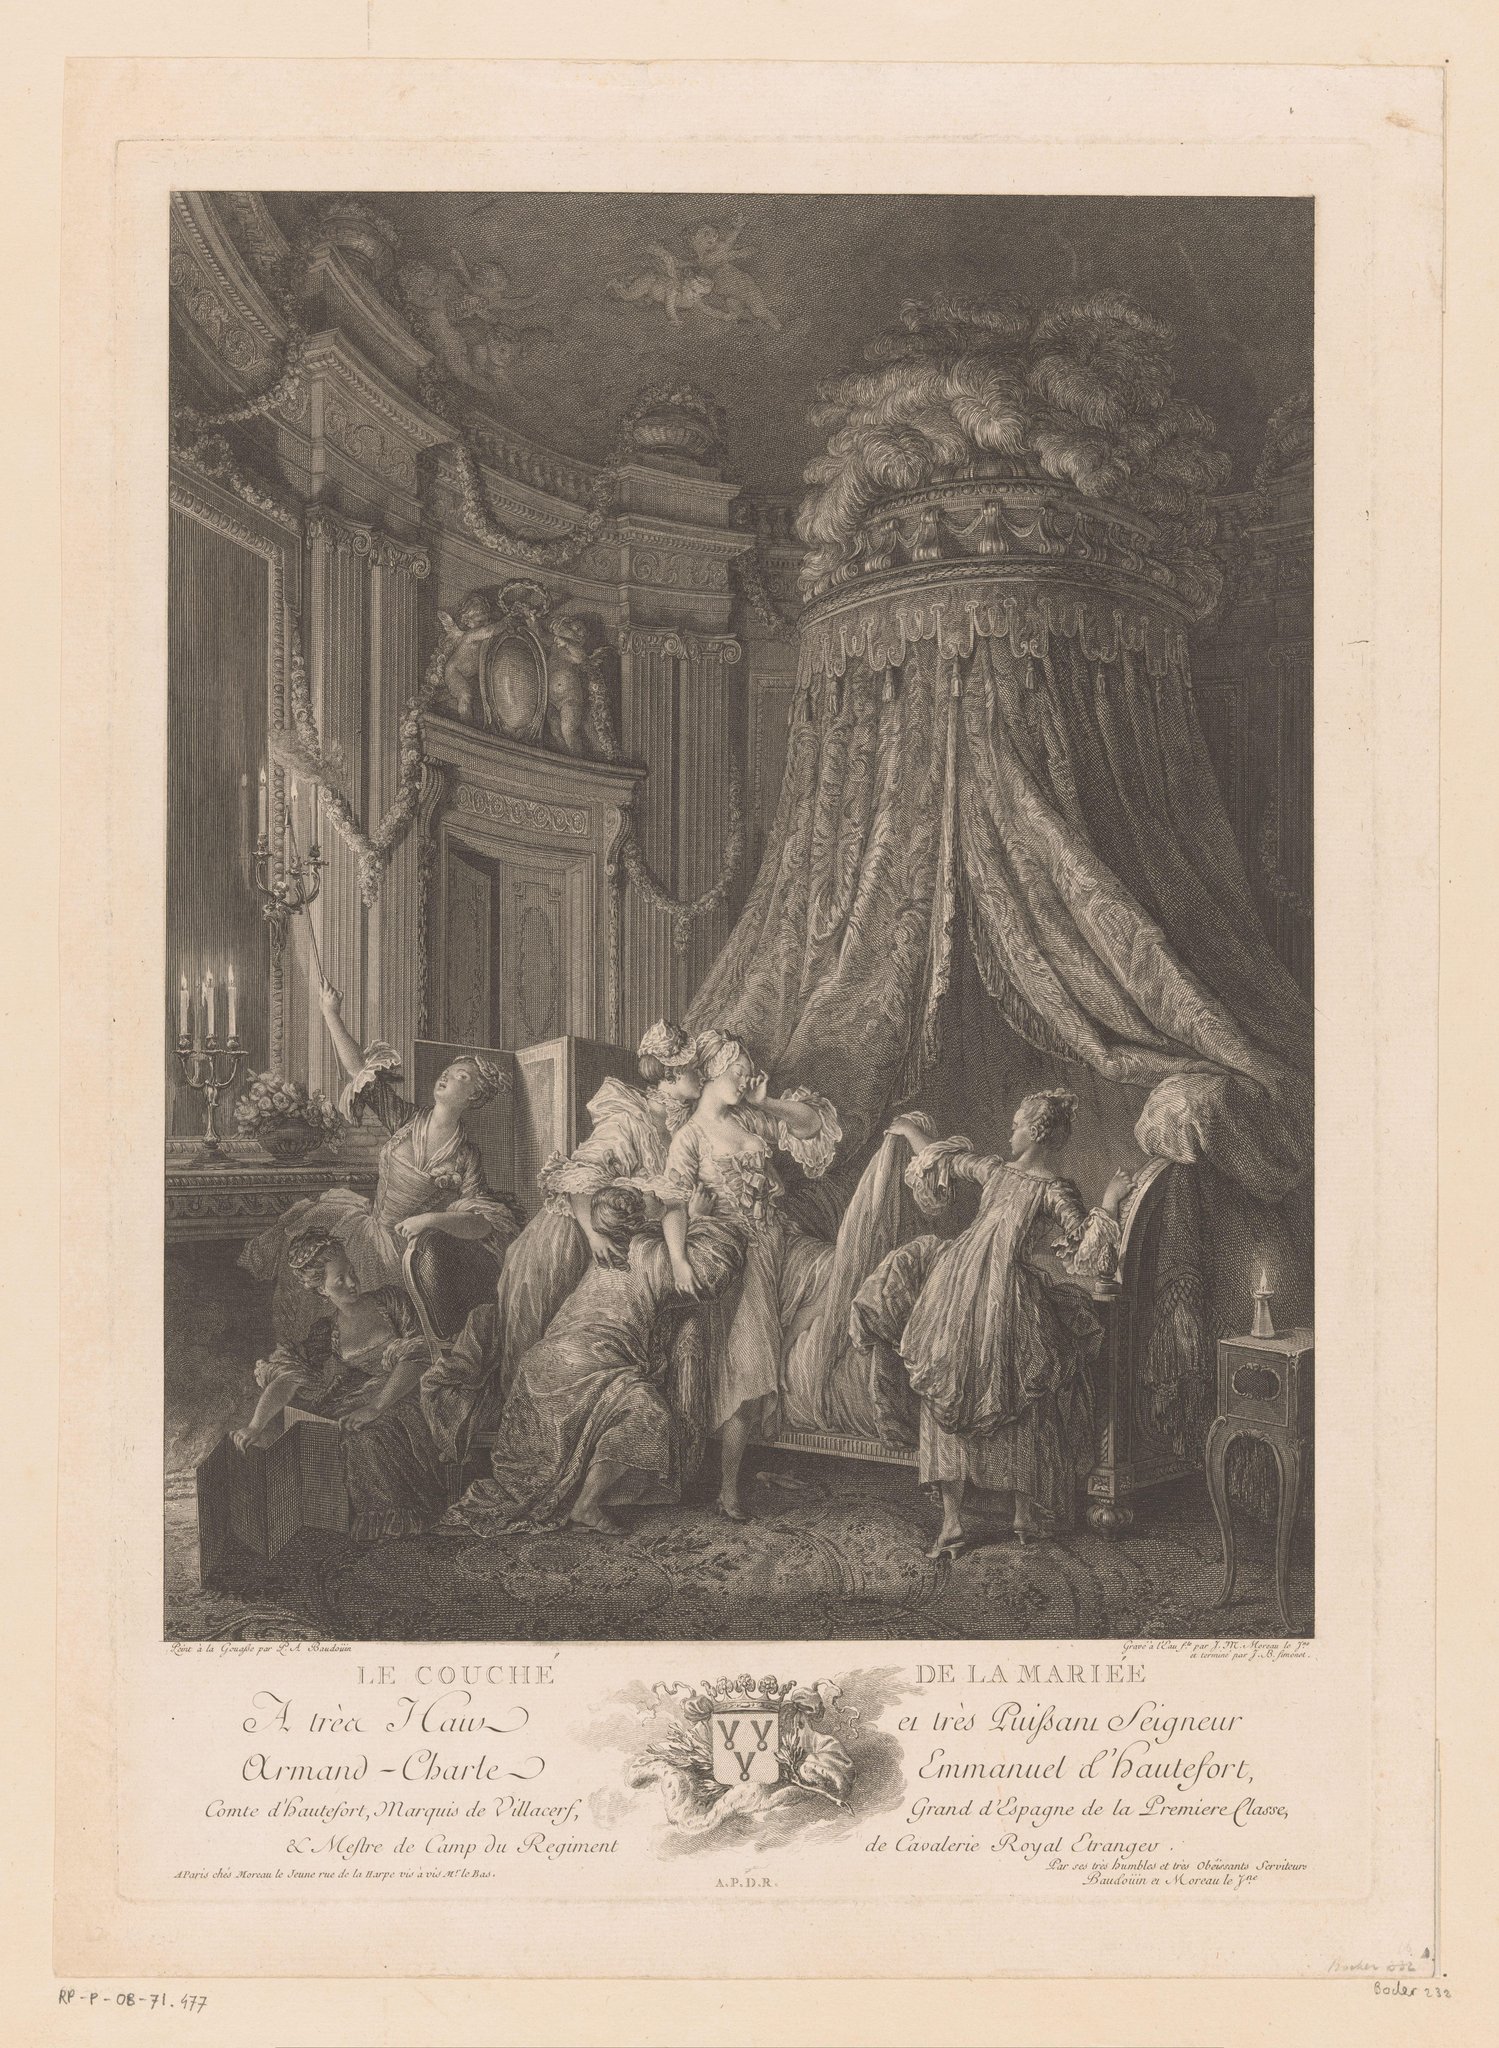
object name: print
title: Le Couché de la Mariée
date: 1770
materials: paper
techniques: engraving, etching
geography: france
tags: bed with tester, going to bed, leading the bride to bed, underclothes and nightwear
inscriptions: collector's mark: Lugt 240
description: Een jonge vrouw in nachtjapon en nachtmuts op, in haar ogen wrijvend, wordt door twee kameniers in haar hemelbed geholpen. Haar jonge echtgenoot zit op zijn knieën naast haar. Links worden haardvuur en kaarsen gedoofd.